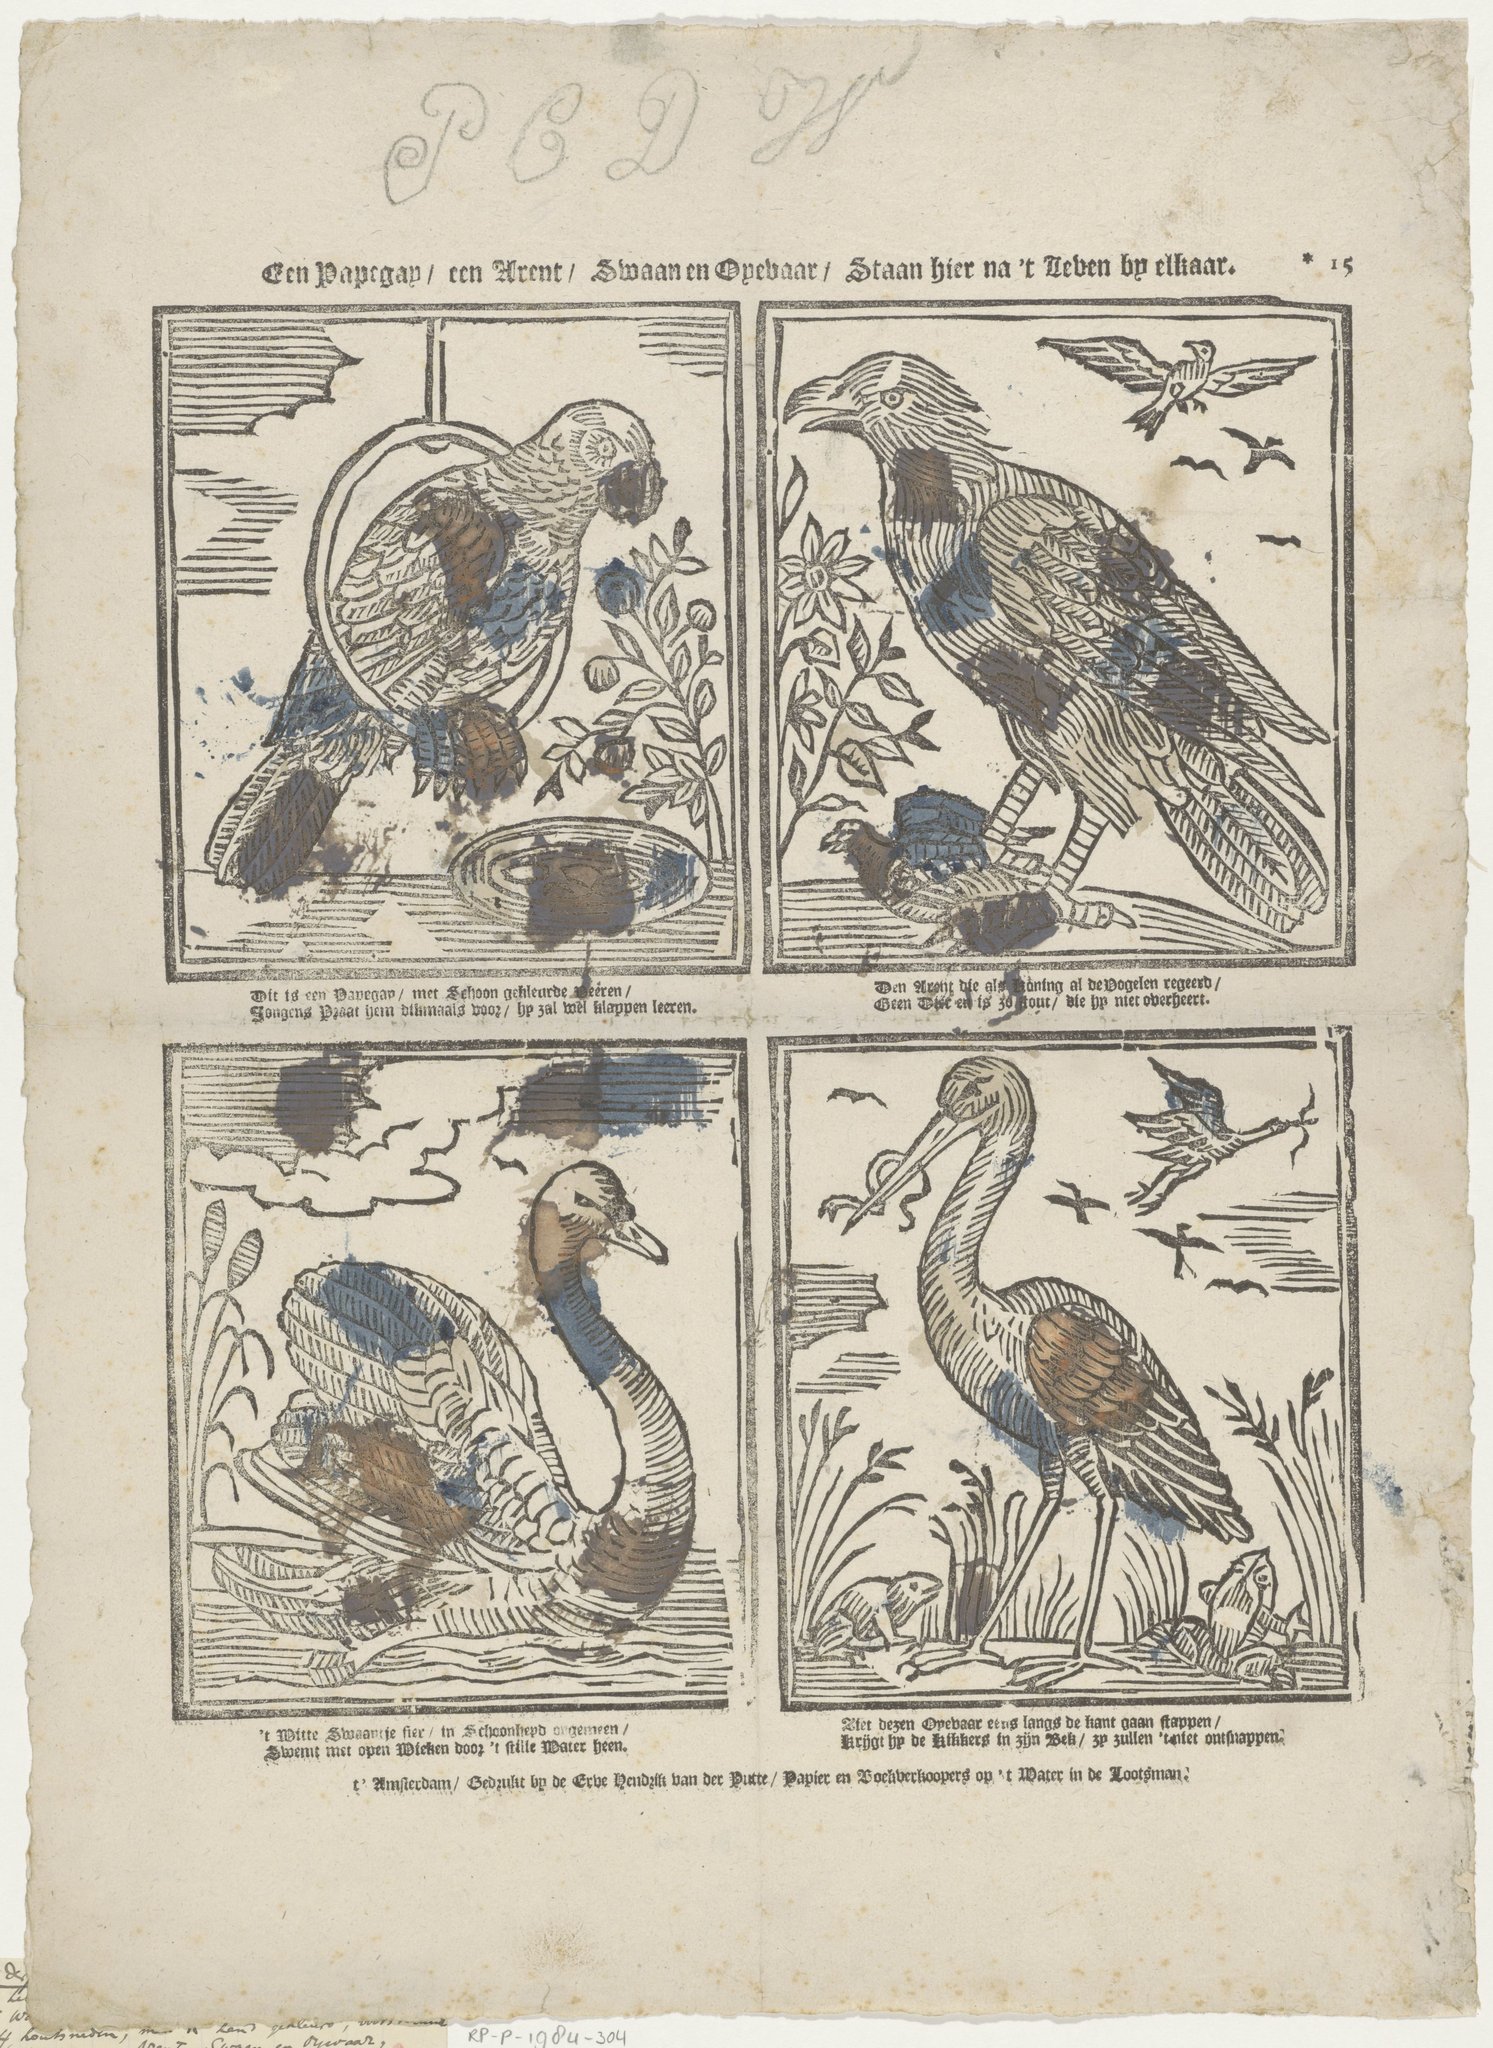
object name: print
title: Een papegaay / een arent / swaan en oyevaar / Staan hier na 't leven by elkaar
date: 1770-1794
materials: paper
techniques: colour, letterpress printing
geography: amsterdam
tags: predatory birds: eagle, shore-birds and wading-birds: stork, water-birds: swan, birds, ornamental birds: parrot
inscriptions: collector's mark: Lugt 2760, collector's mark: Lugt 2228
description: Blad met 4 voorstellingen van vogels: een papegaai, een arend, een zwaan en een ooievaar. Onder elke afbeelding een vers. Genummerd rechtsboven: *15.